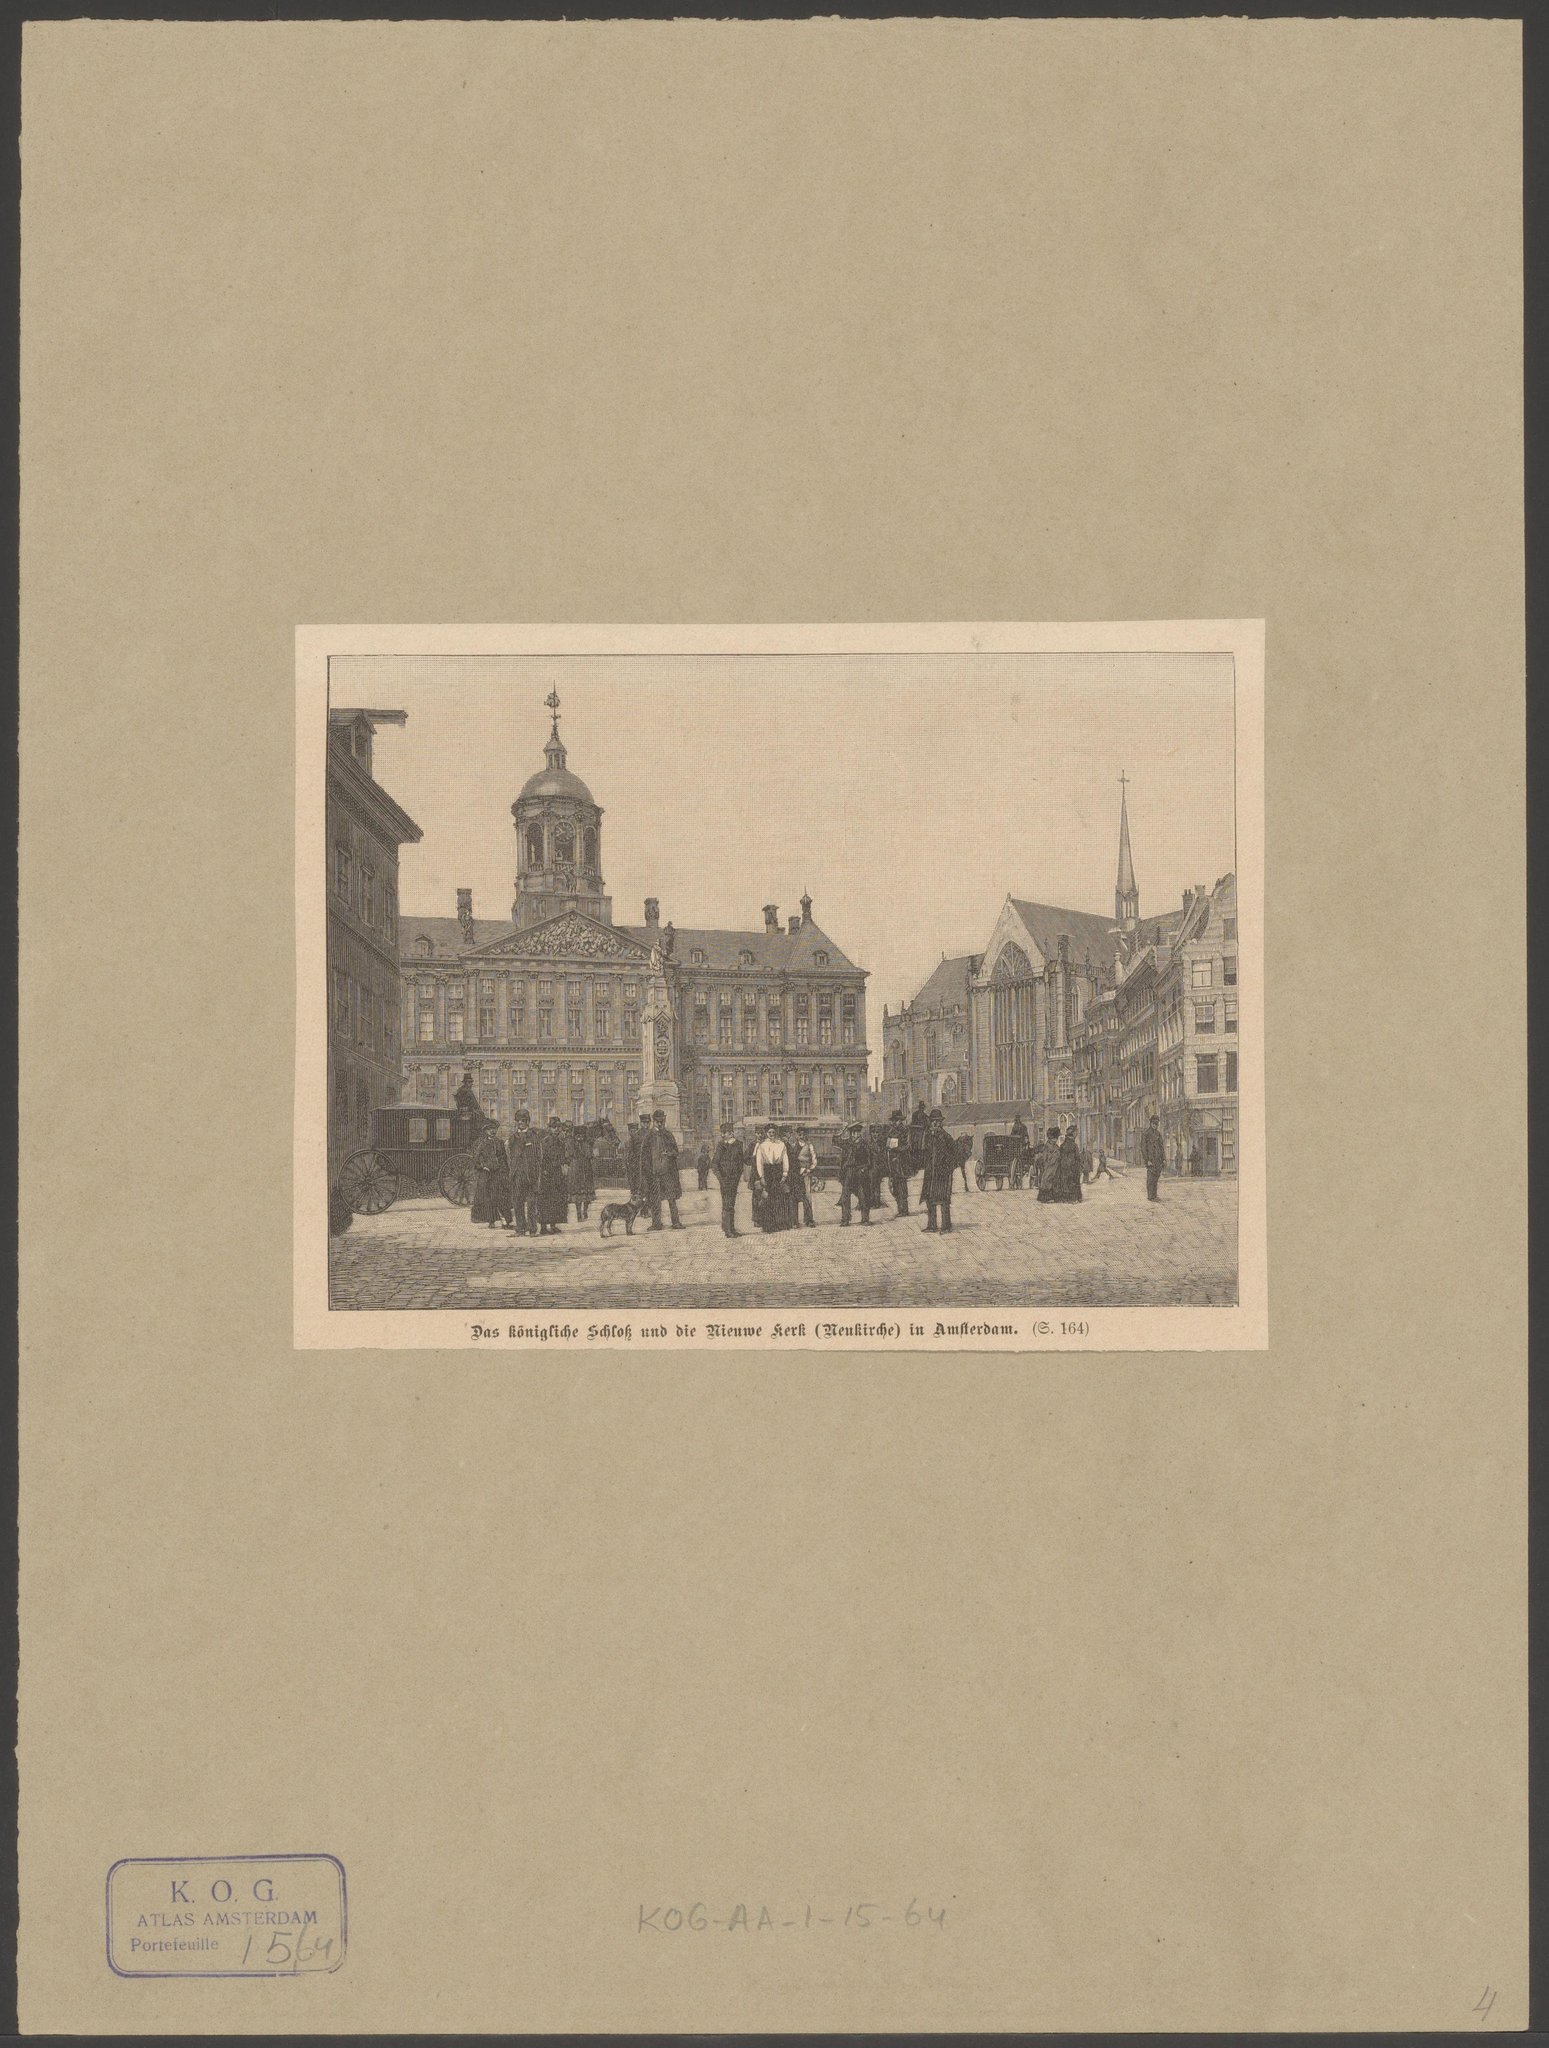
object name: print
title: Gezicht op het Paleis op de Dam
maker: Anonymous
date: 1850-1950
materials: paper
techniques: letterpress printing, engraving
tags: square, place, circus, etc., city-view in general; 'veduta', palace, church (exterior), royal palace of amsterdam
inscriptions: collector's mark: ‘15,64’ Lugt 1641b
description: Onderwerpsrubriek binnen de Atlas Amsterdam: Nieuwe Stadhuis, als Paleis, op de Dam, van Buiten.